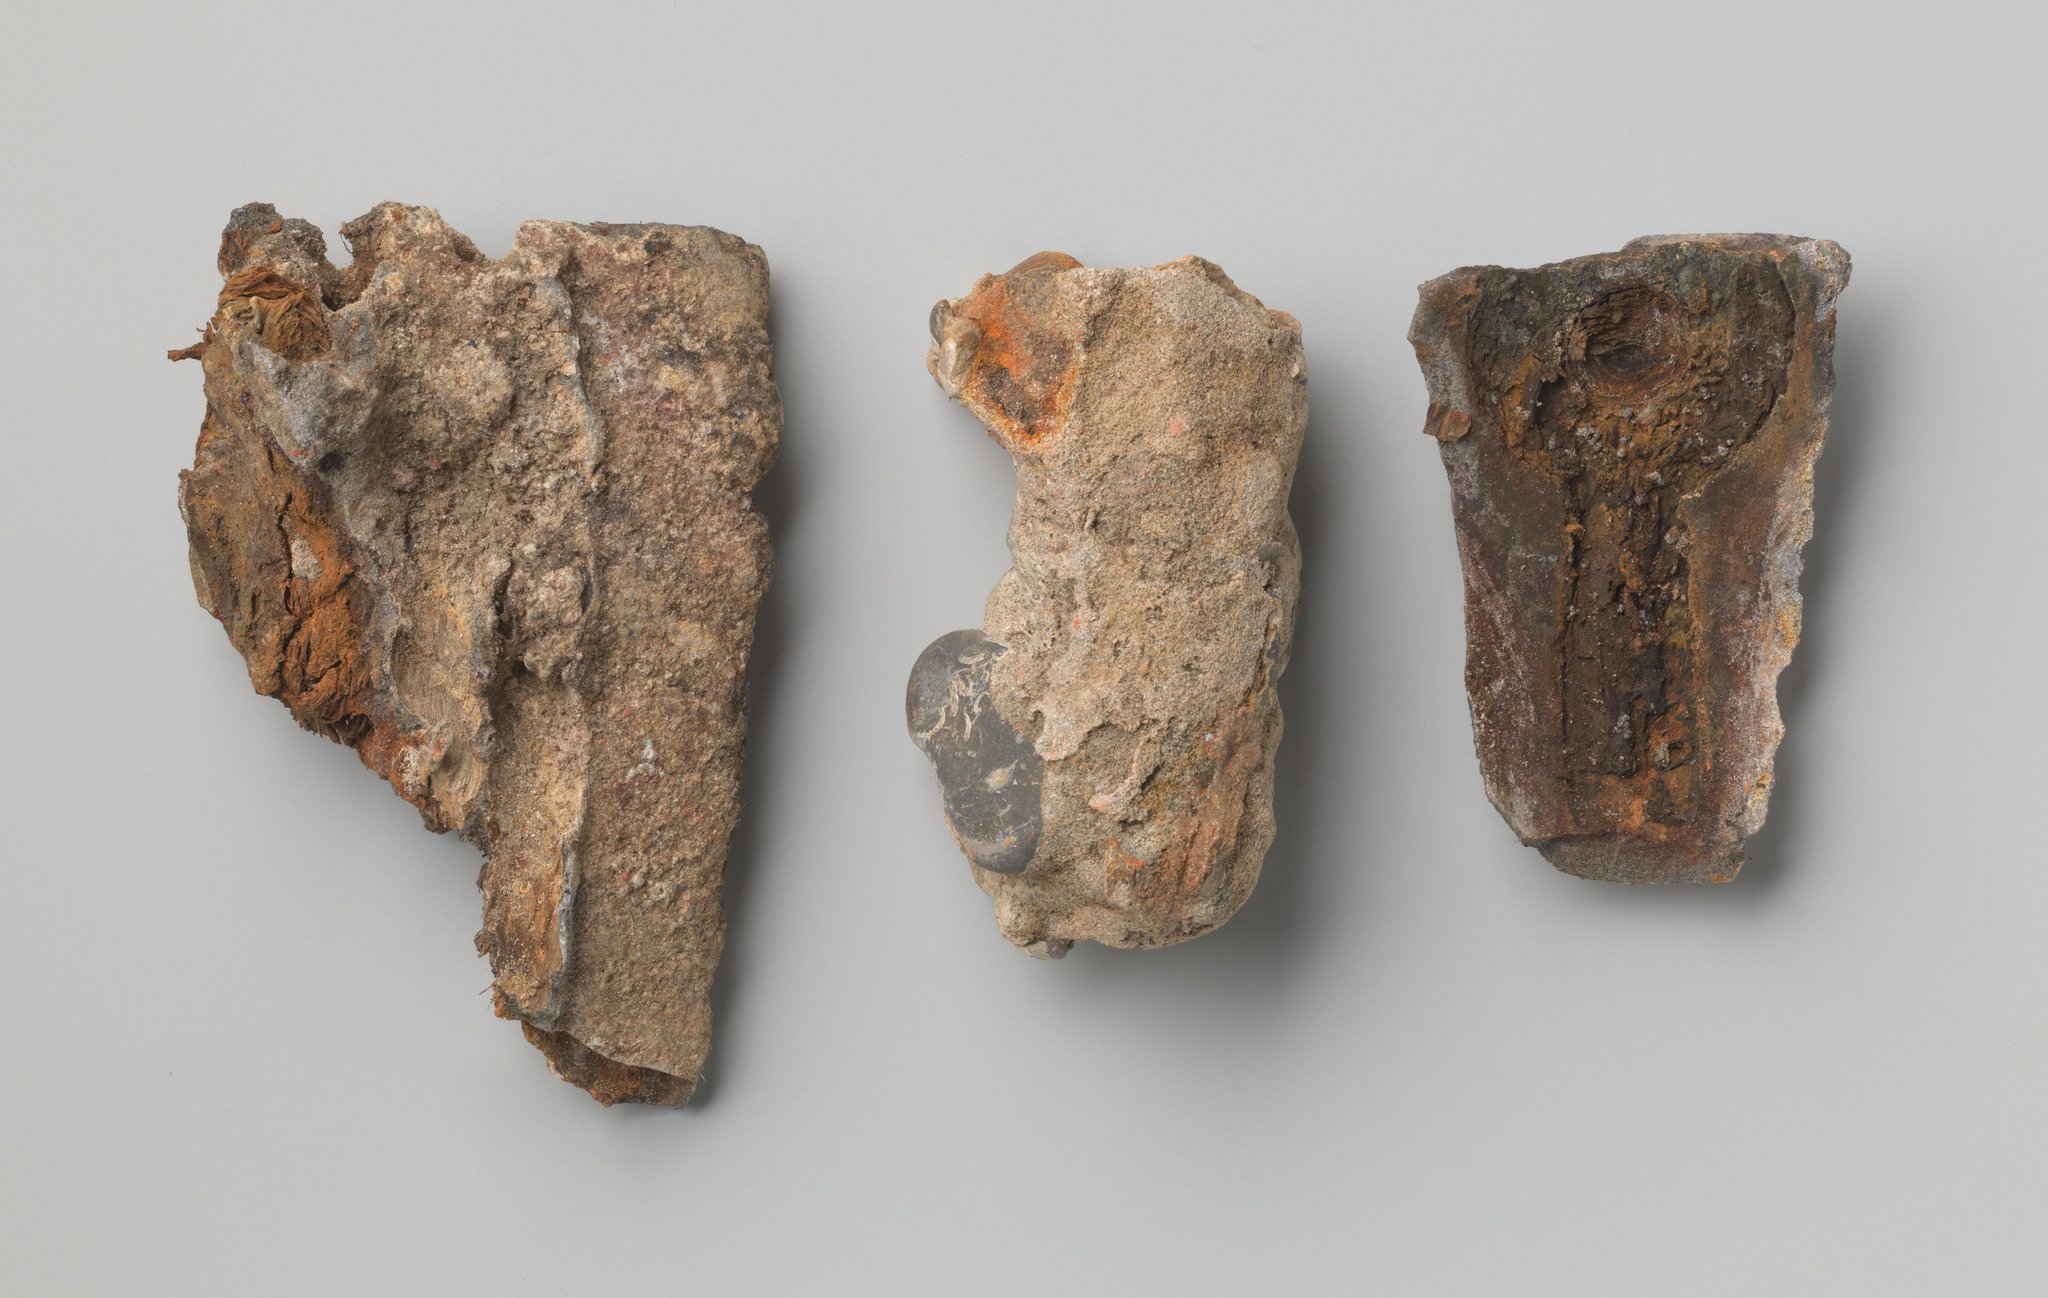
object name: concretionary stone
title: Drie brokken concretie uit V.O.C.-schip Zeelelie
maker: Anonymous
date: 1795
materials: stone, metal, fiber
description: Drie brokken concretie met de afdrukken en resten van metaal en touw een aankoeksels van de zeebodem.